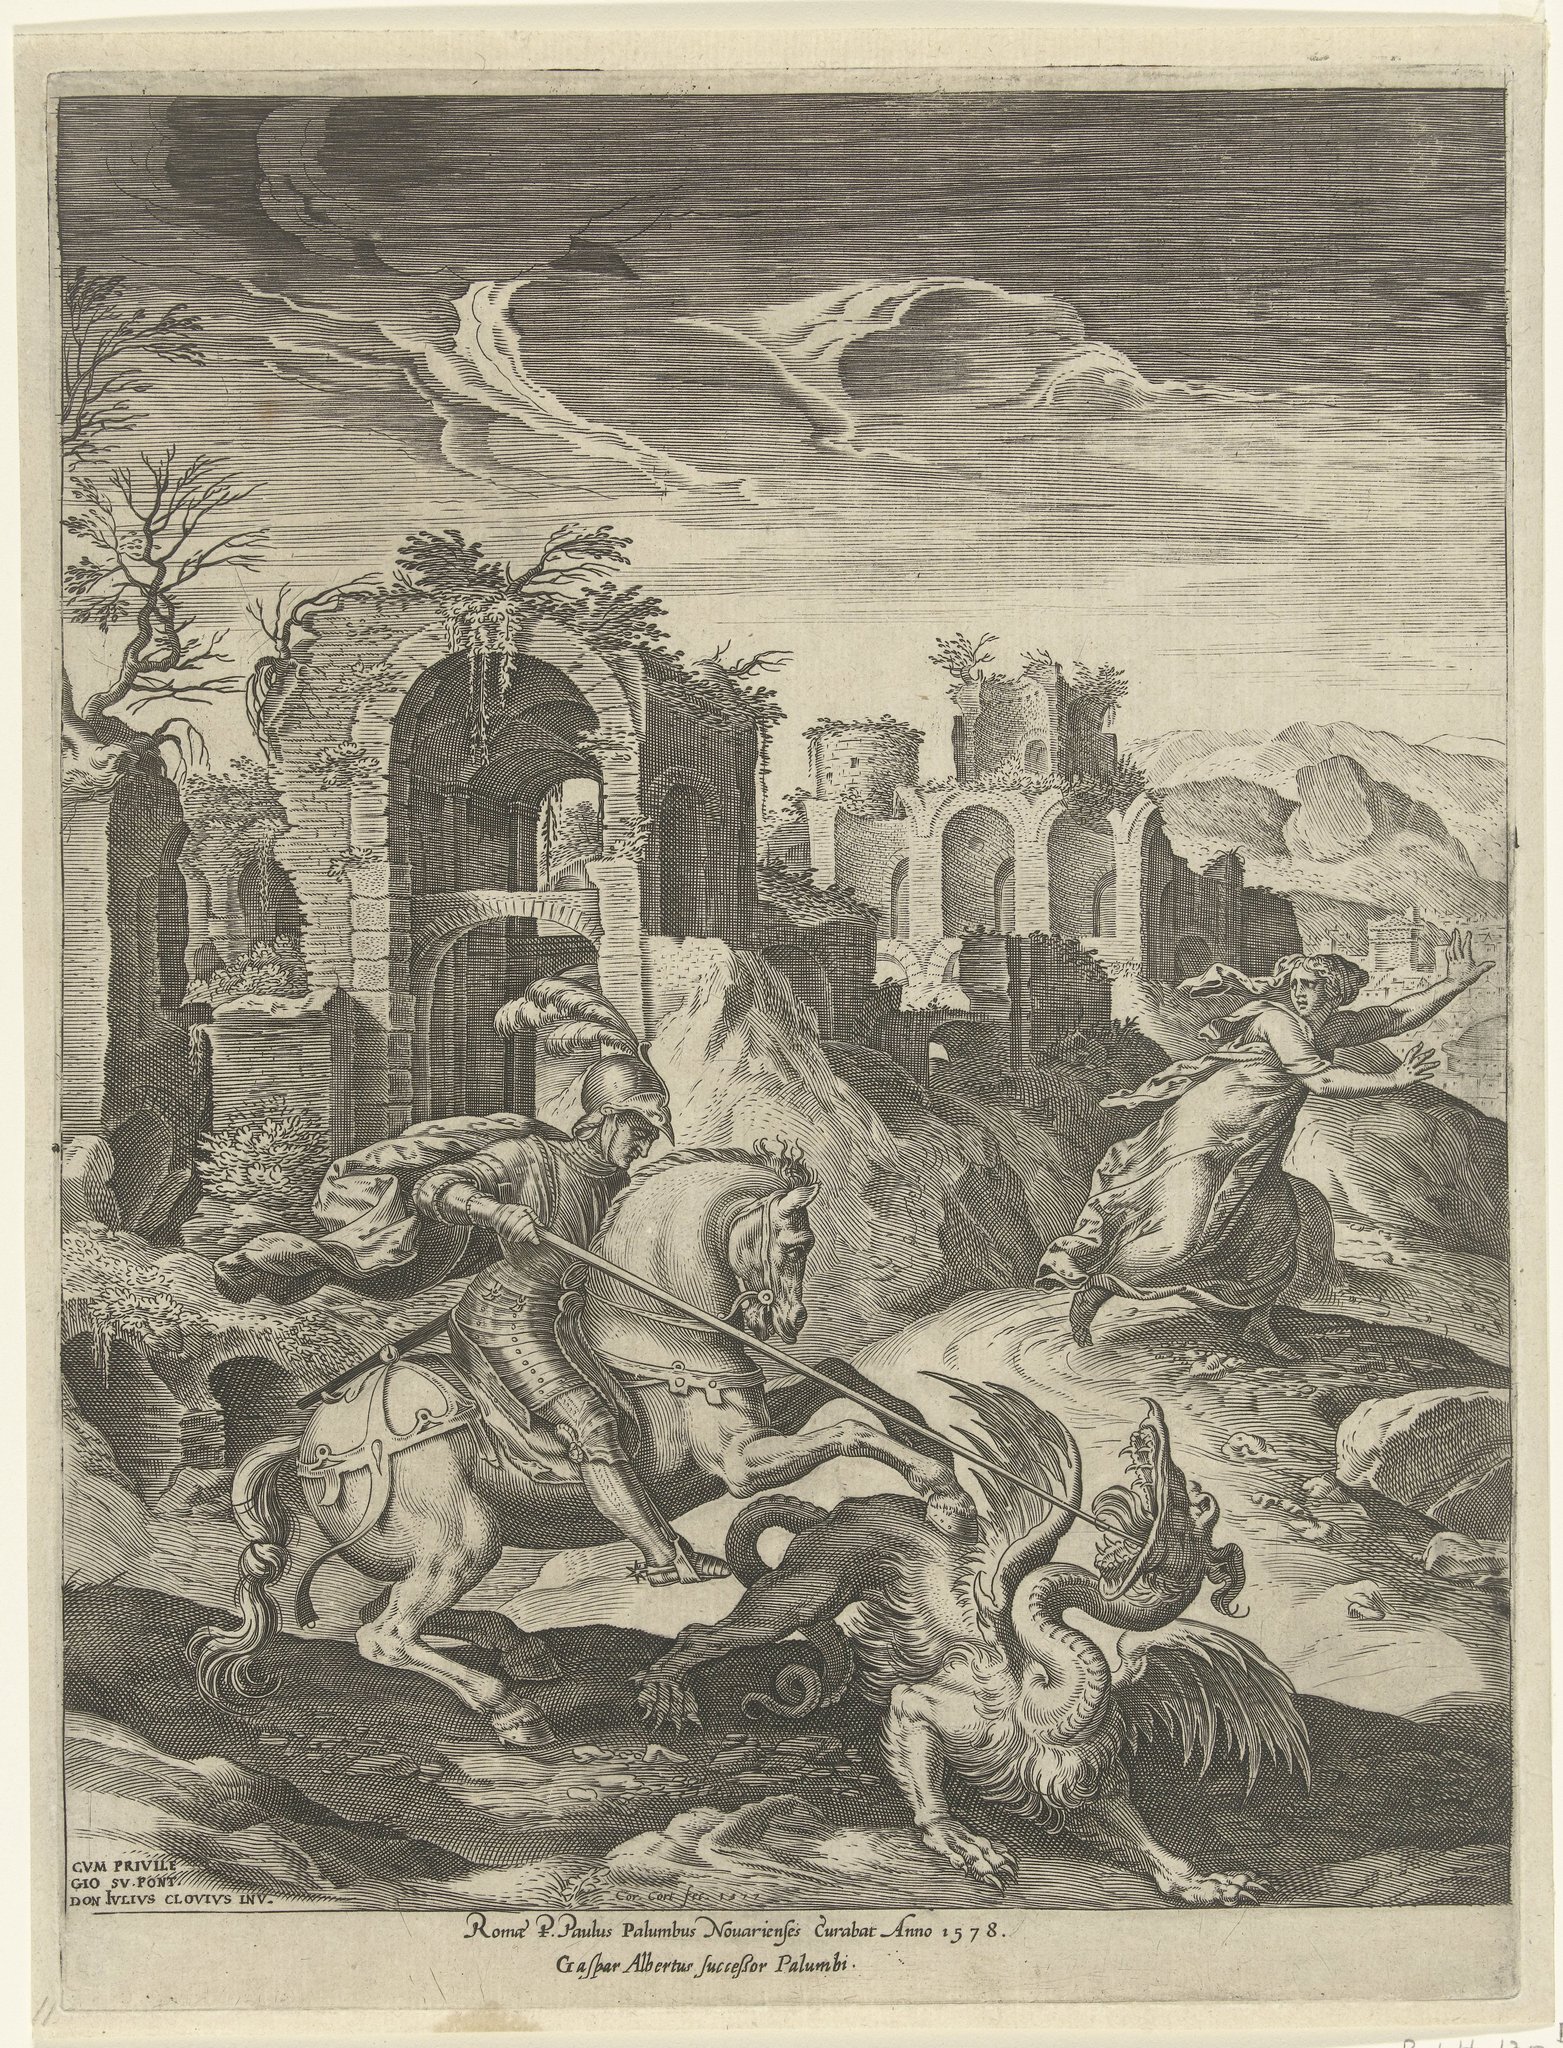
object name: print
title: Joris doodt de draak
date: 1578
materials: paper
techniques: engraving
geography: rome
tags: the warrior martyr george (georgius); possible attributes: banner (red cross on white field), (red) cross, dragon, (white) horse, broken lance, shield (with cross), sword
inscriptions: collector's mark: Lugt 2228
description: De heilige Joris doodt de draak. Een vrouw vlucht in paniek voor de draak. Op de achtergrond een landschap met ruines van Romeinse gebouwen.